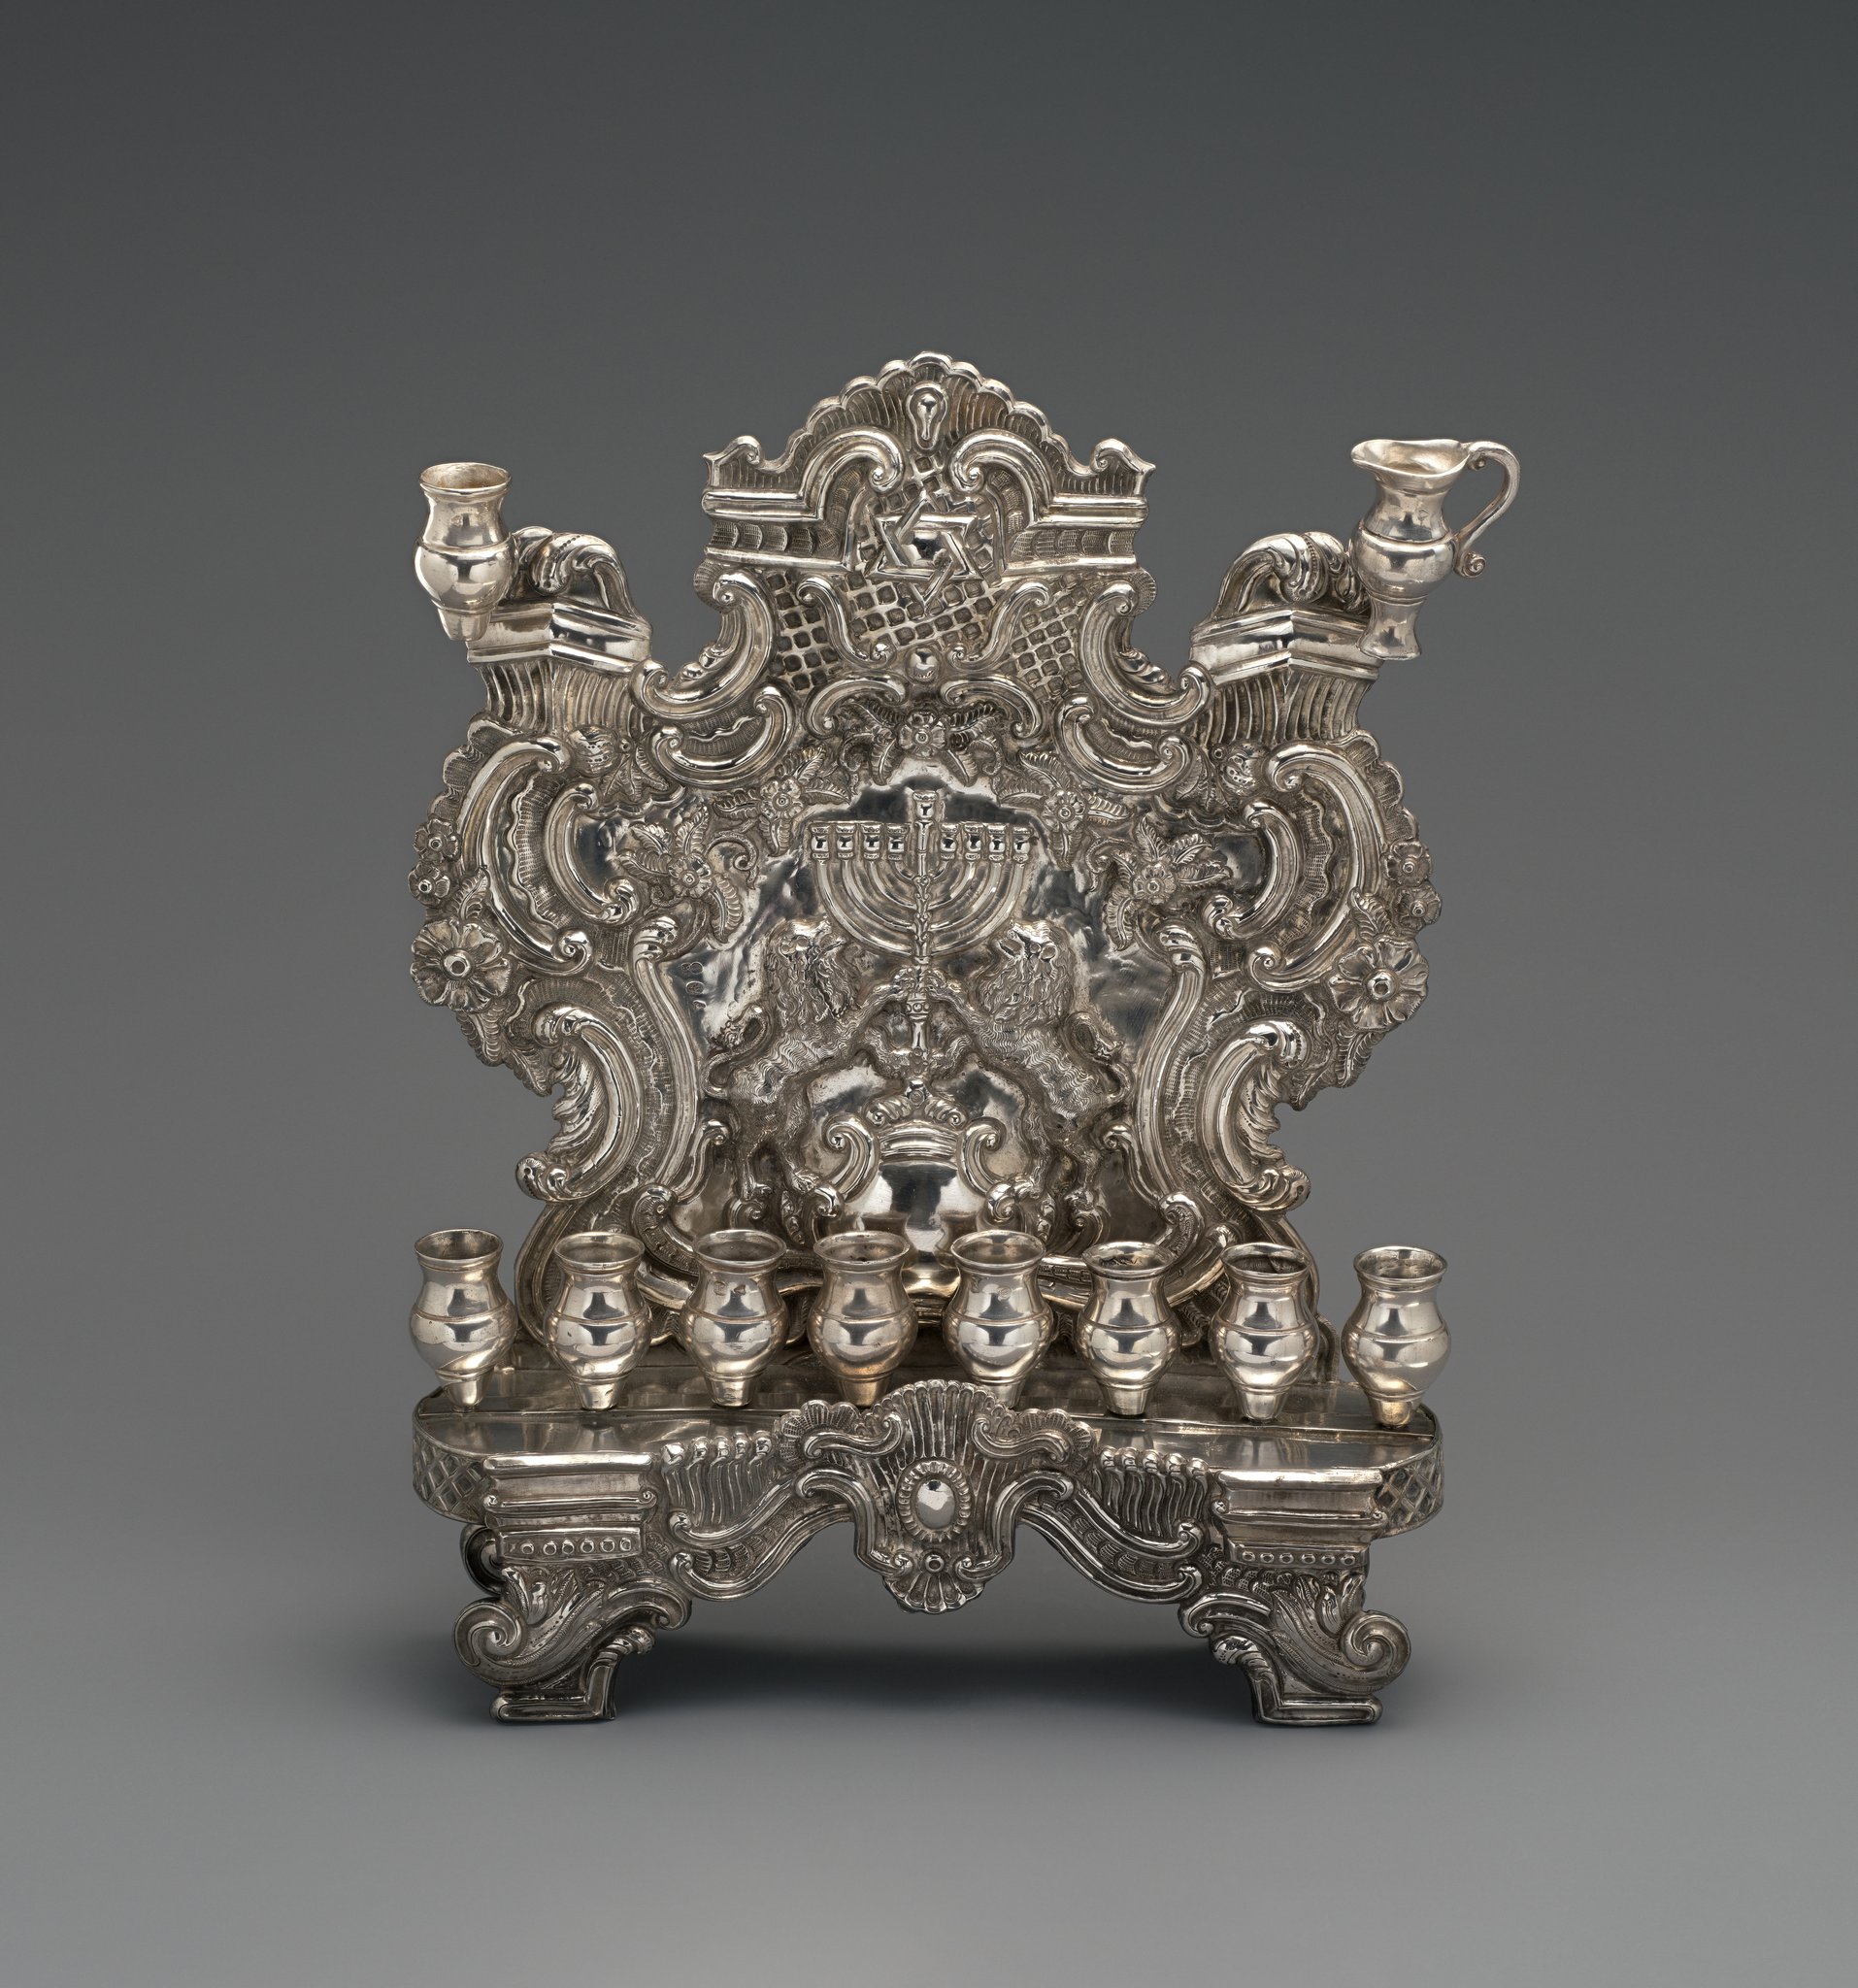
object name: hanukkah lamp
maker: pietro borrani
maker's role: maker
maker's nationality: italian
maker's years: 1824-1873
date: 1830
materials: silver